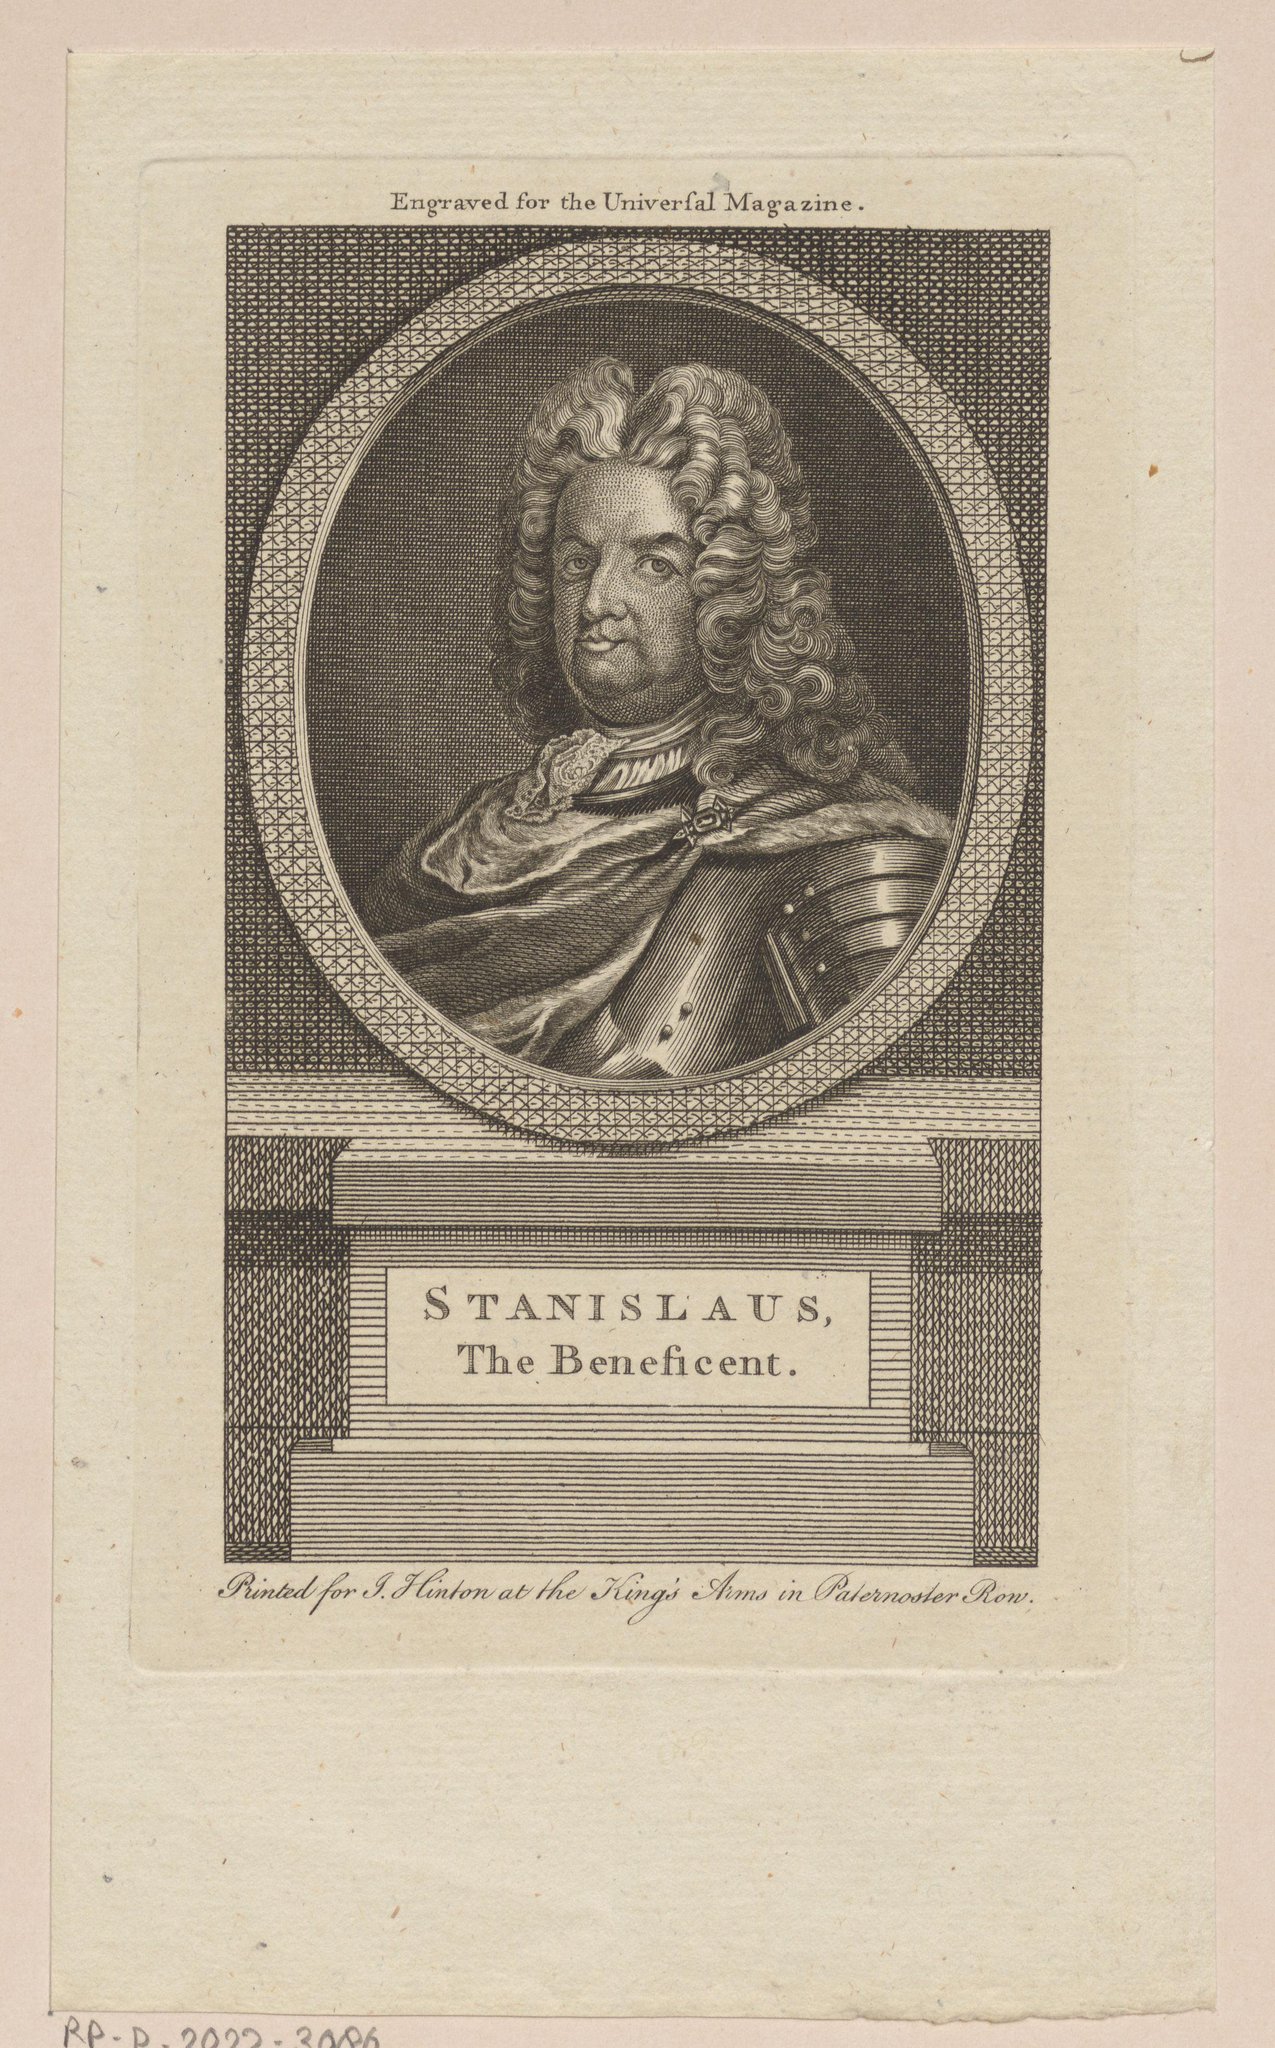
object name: print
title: Portret van Stanislaus Leszczyński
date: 1703-1773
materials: paper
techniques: engraving, etching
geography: london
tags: historical persons, king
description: Prent waarschijnlijk uit: The Universal Magazine of Knowledge and Pleasure 52 of 53 (1773), maart 1773.